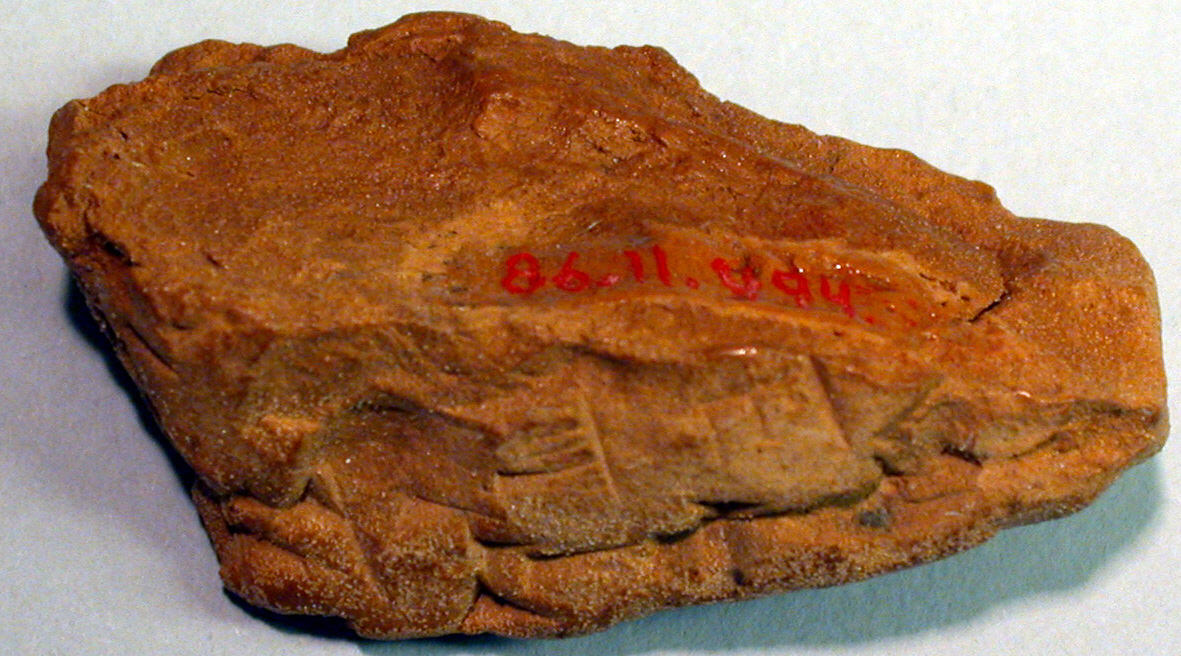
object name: cuneiform tablet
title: Cuneiform tablet: fragment, Ebabbar archive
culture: achaemenid or babylonian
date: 700-301 BCE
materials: clay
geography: mesopotamia